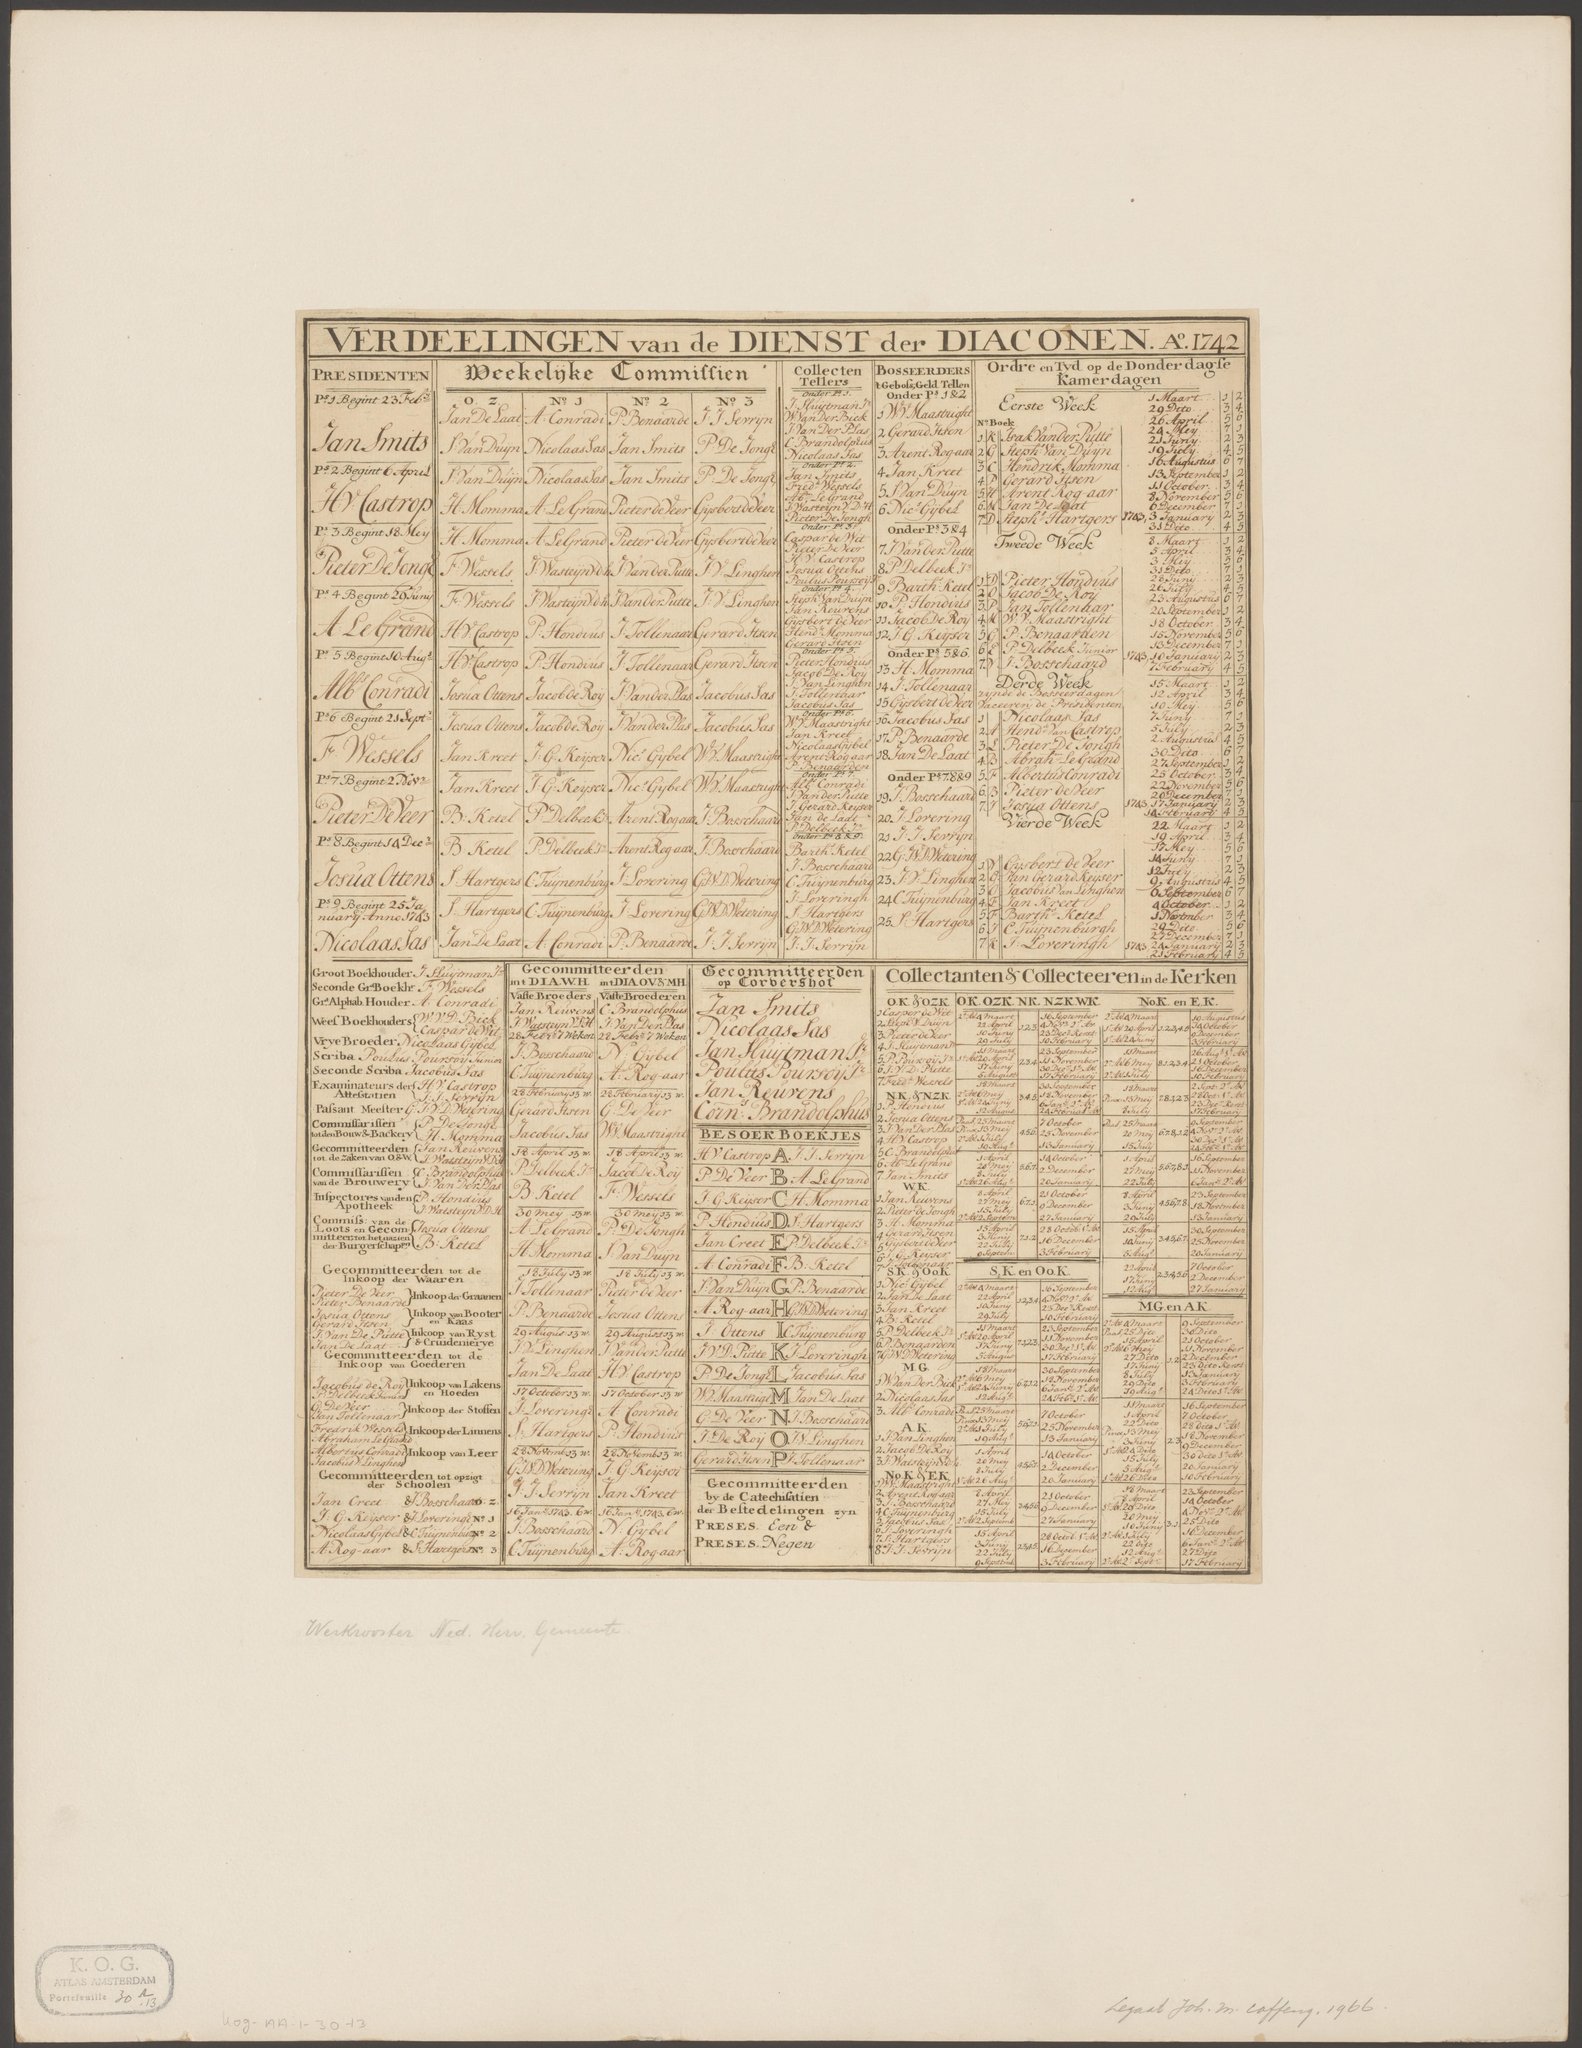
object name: rooster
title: Verdeelingen van de dienst der diaconen Ao. 1742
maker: Anonymous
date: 1742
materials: ink, paper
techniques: engraving, pen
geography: northern netherlands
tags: protestant churches and denominations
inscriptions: collector's mark: Lugt 1641b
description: Onderwerpsrubriek binnen de Atlas Amsterdam: Kerkwezen: Verzamelbladen protestantse kerken.